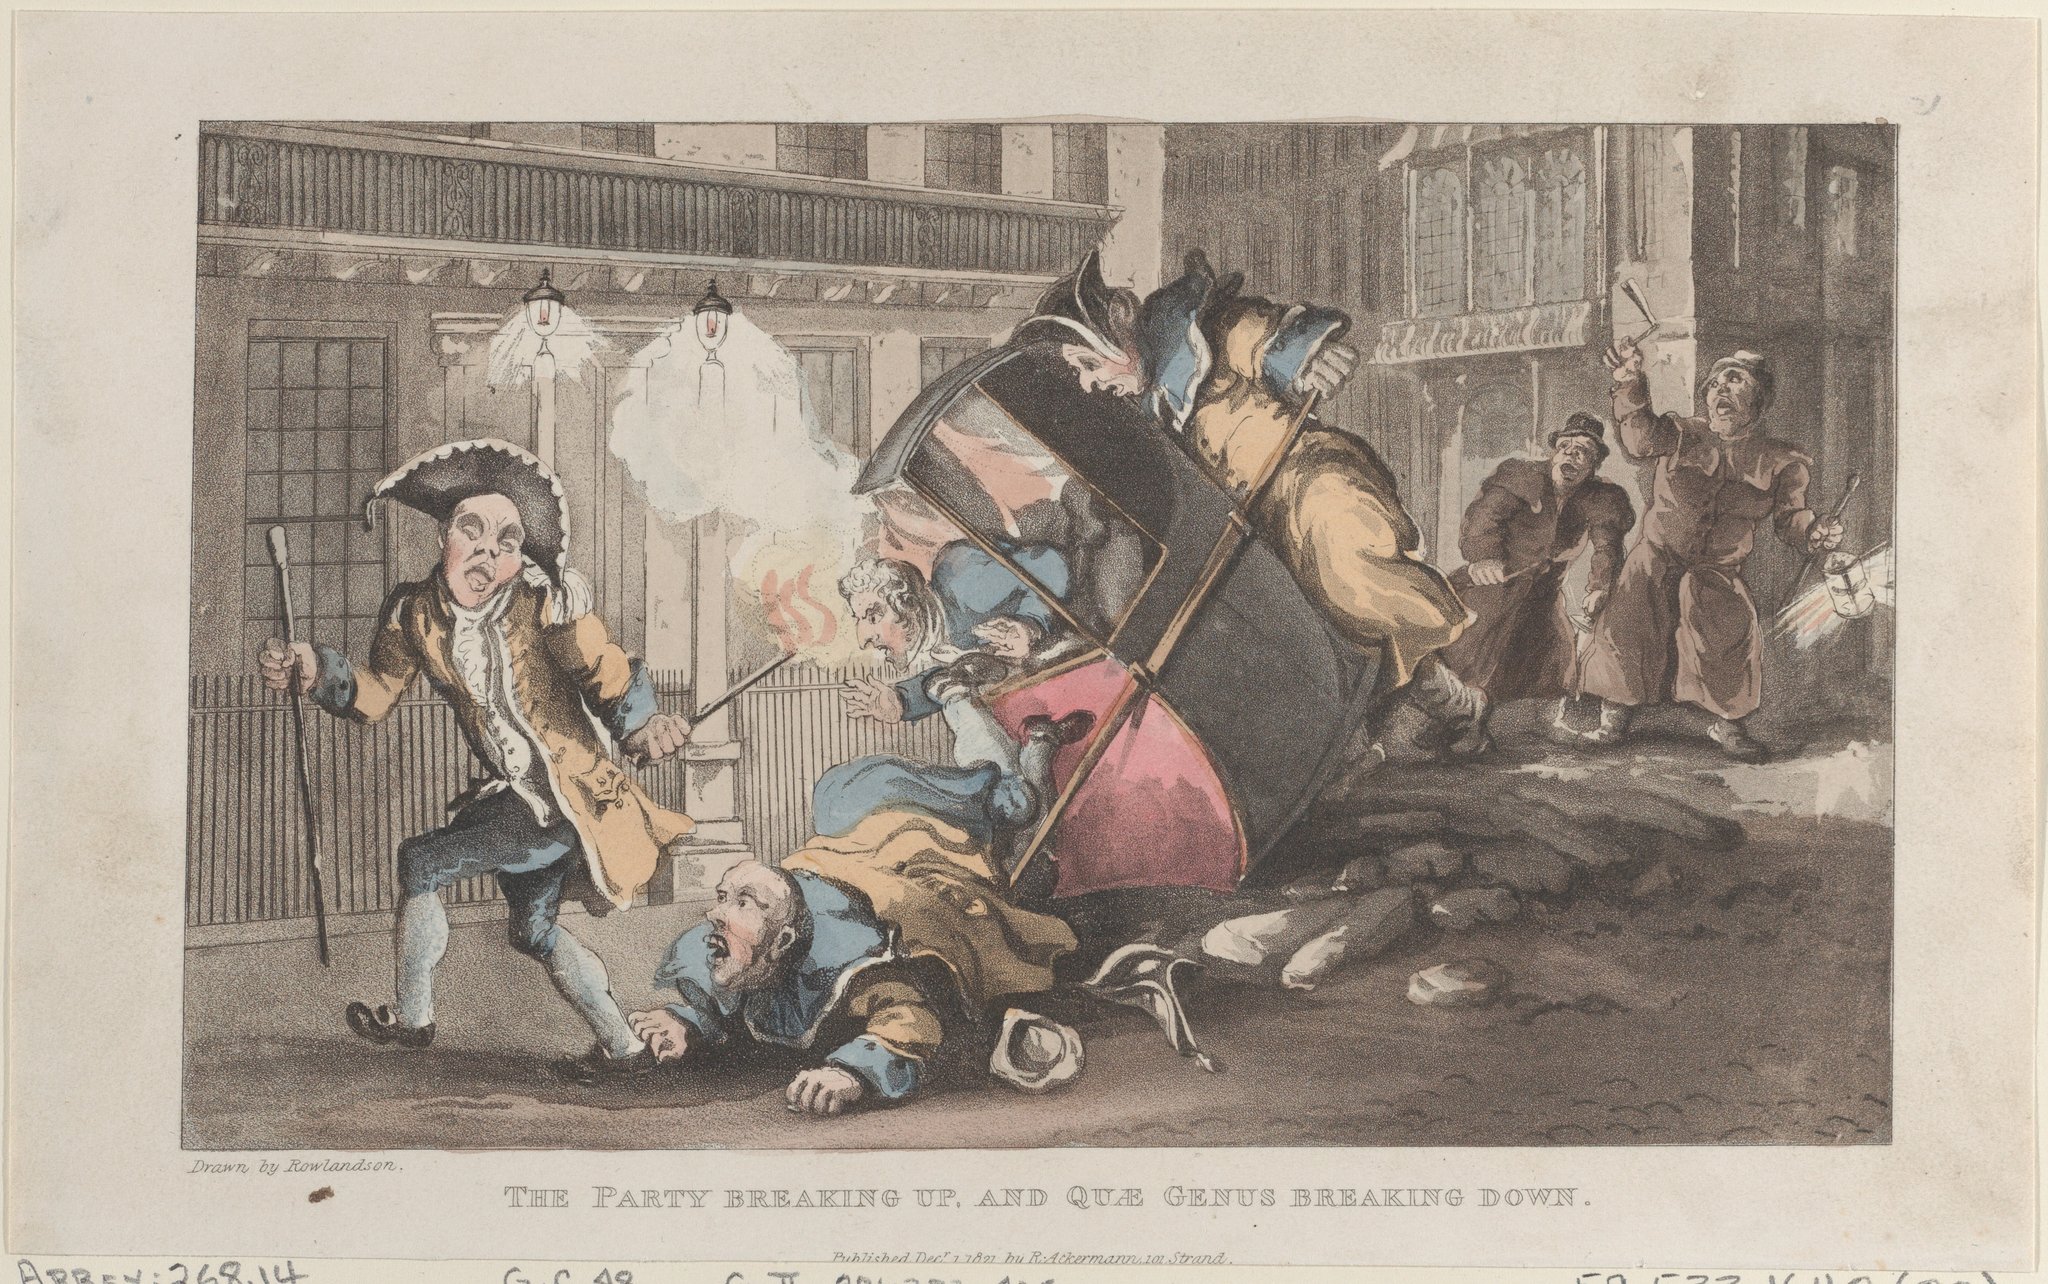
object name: print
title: The Party Breaking Up, and Quae Genus Breaking Down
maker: thomas rowlandson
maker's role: artist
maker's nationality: british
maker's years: 1757-1827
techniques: aquatint, etching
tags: men